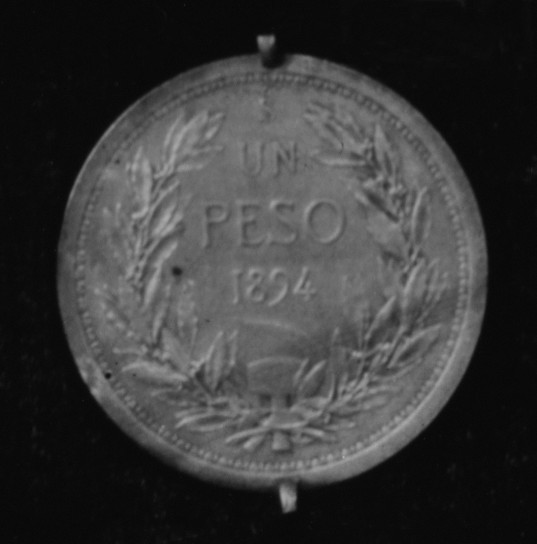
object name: peso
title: Chilean peso piece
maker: louis-oscar roty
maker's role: artist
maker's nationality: french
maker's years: 1846-1911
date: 1894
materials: silver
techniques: struck